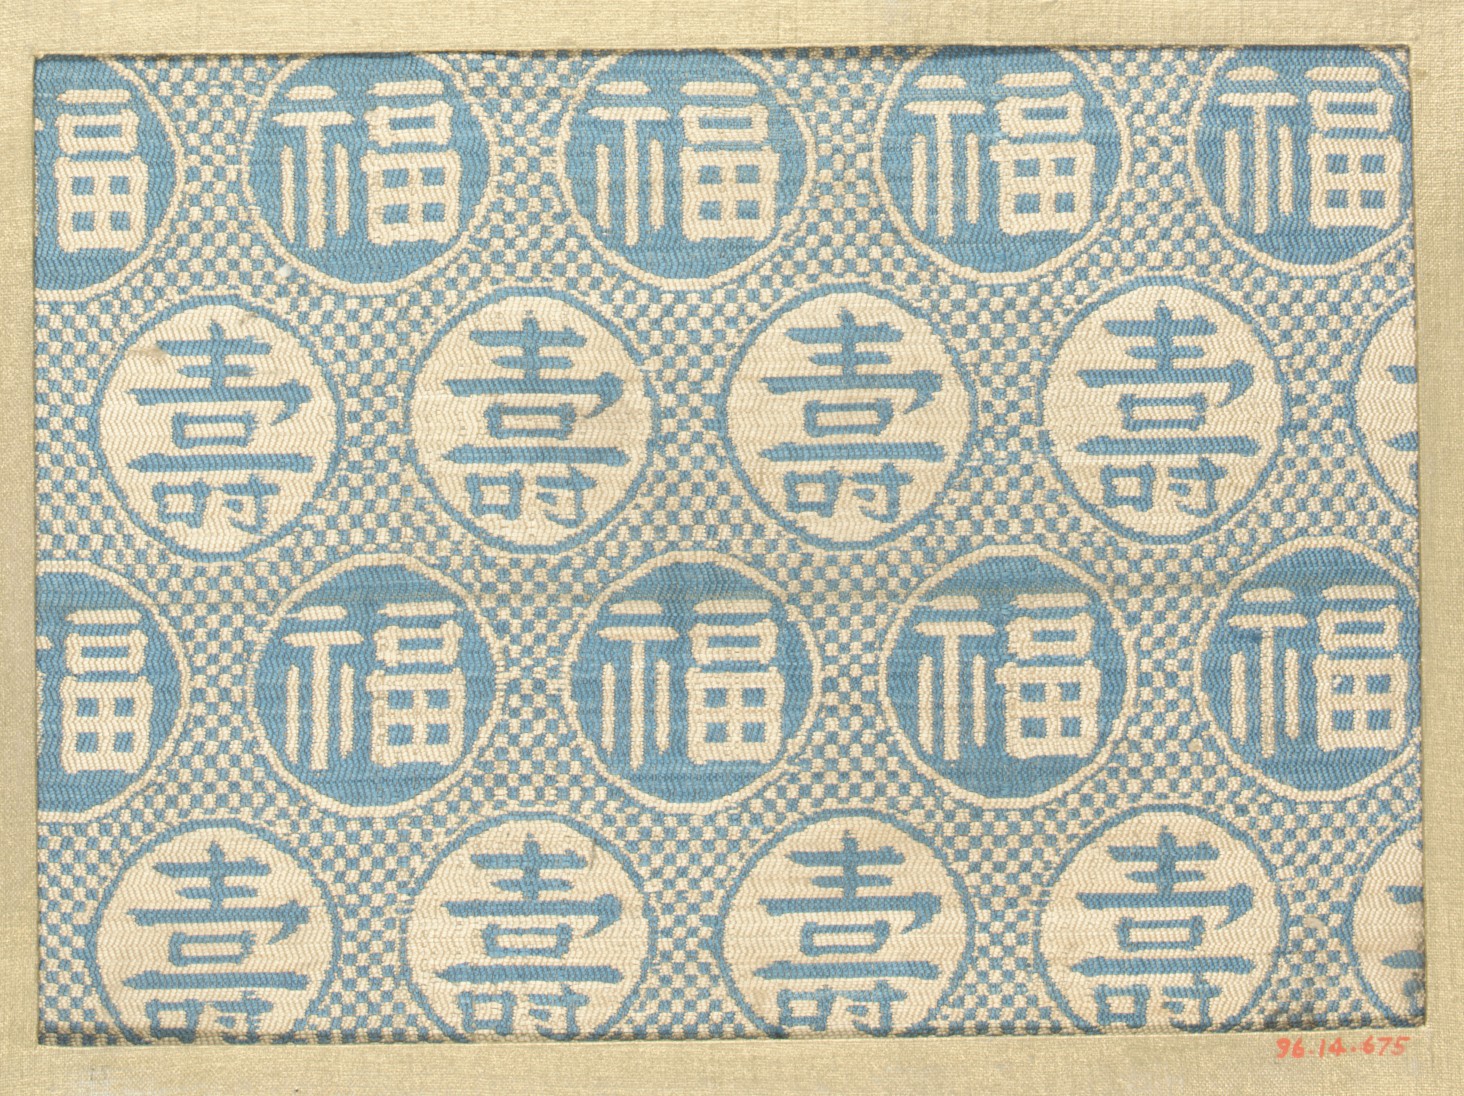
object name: piece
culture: japanese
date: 1701-1900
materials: silk